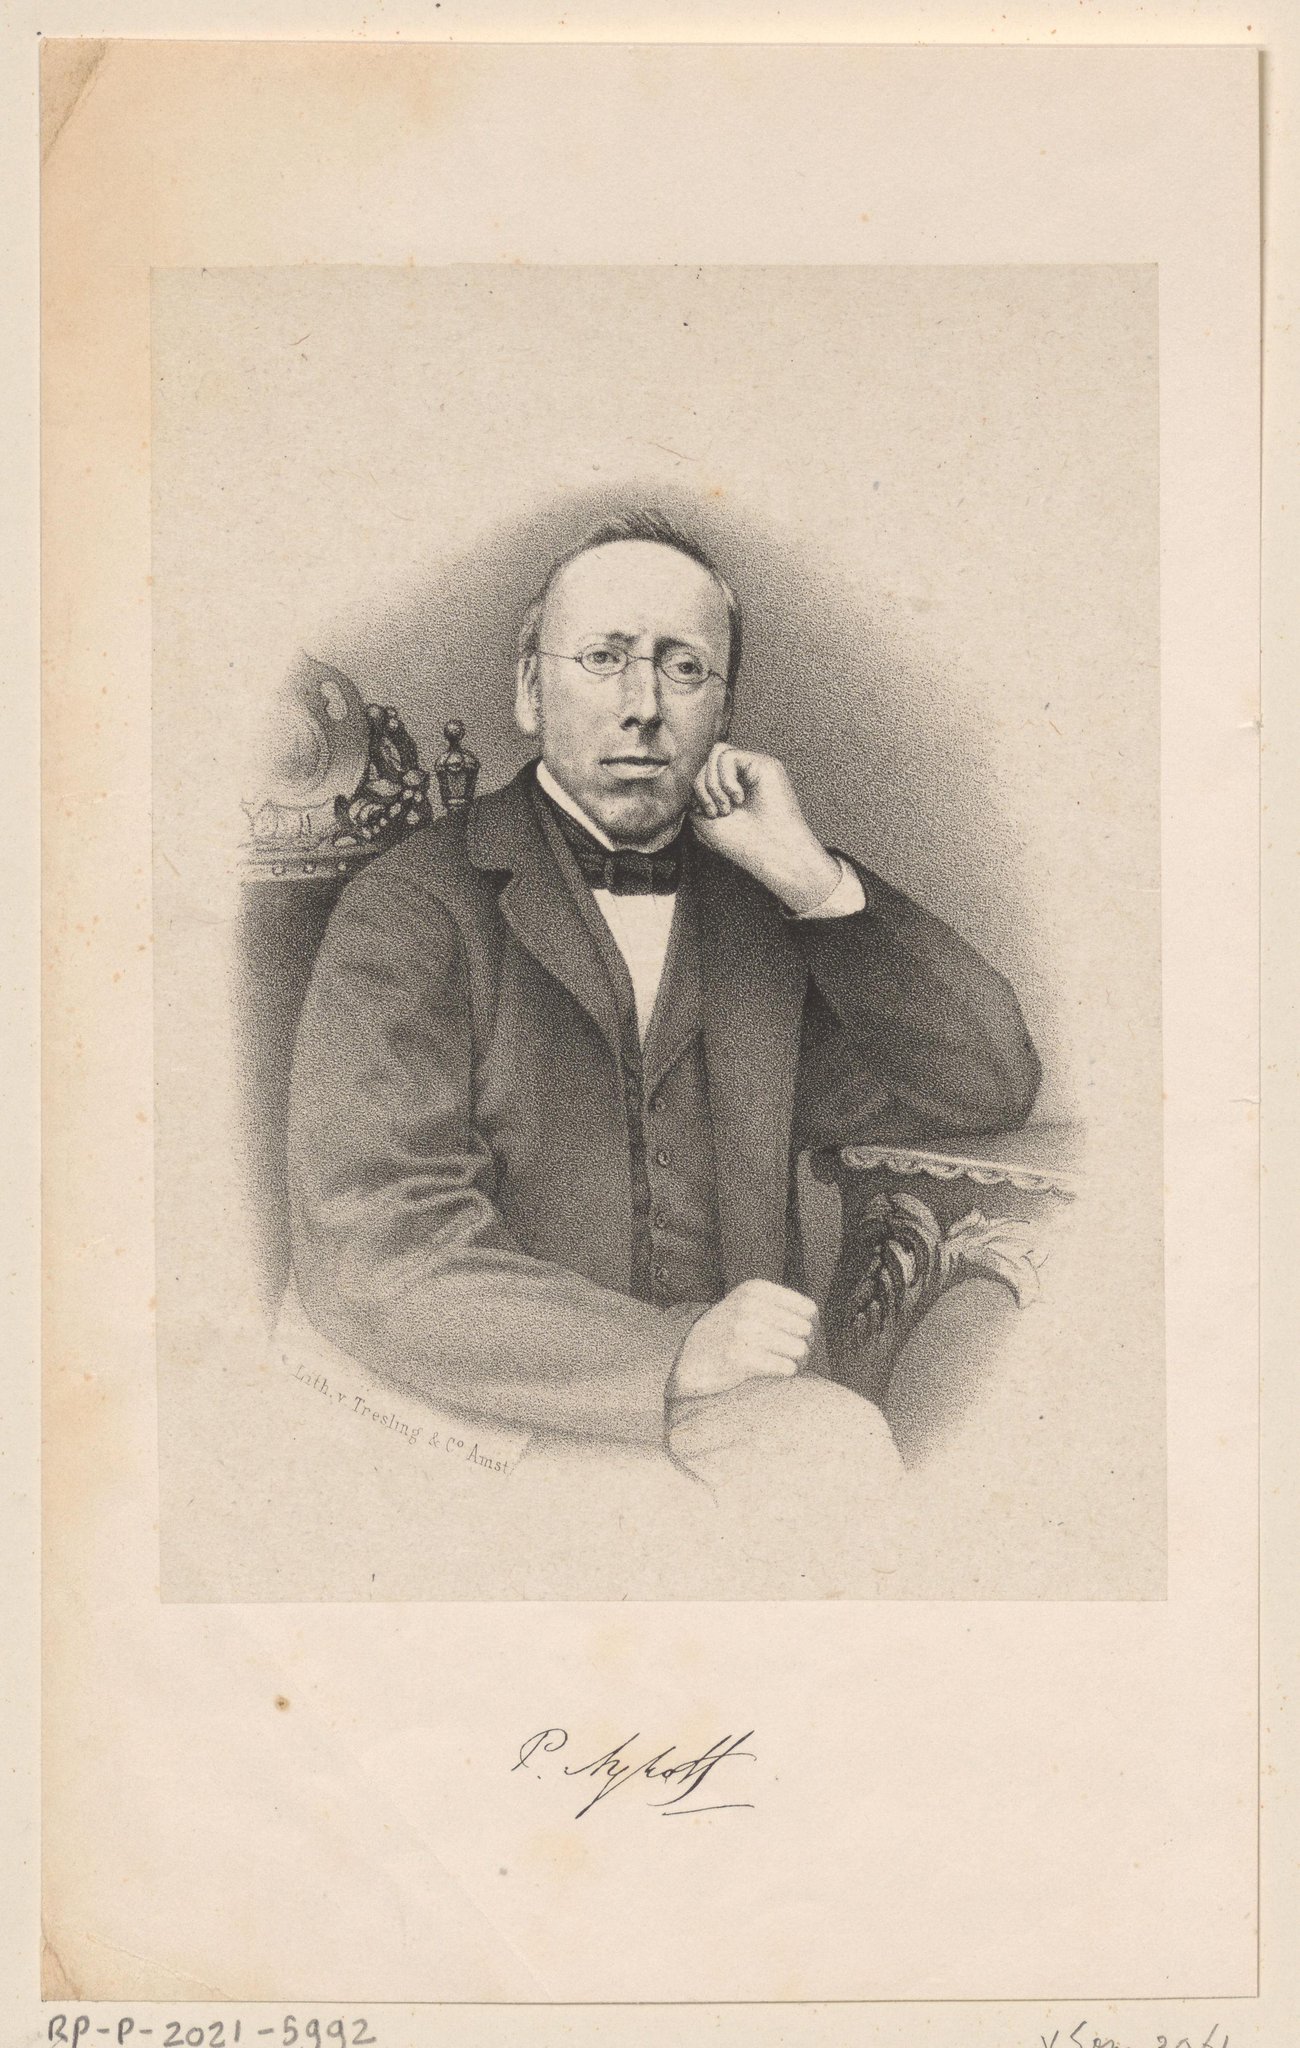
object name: print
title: Portret van Paul Nijhoff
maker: Anonymous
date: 1868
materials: paper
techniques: lithograph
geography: amsterdam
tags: historical persons, publishing, publisher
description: Prent waarschijnlijk uit: Algemeen adresboek voor den Nederlandschen boekhandel en aanverwante vakken (...). Amsterdam: C.L. Brinkman, 1868.